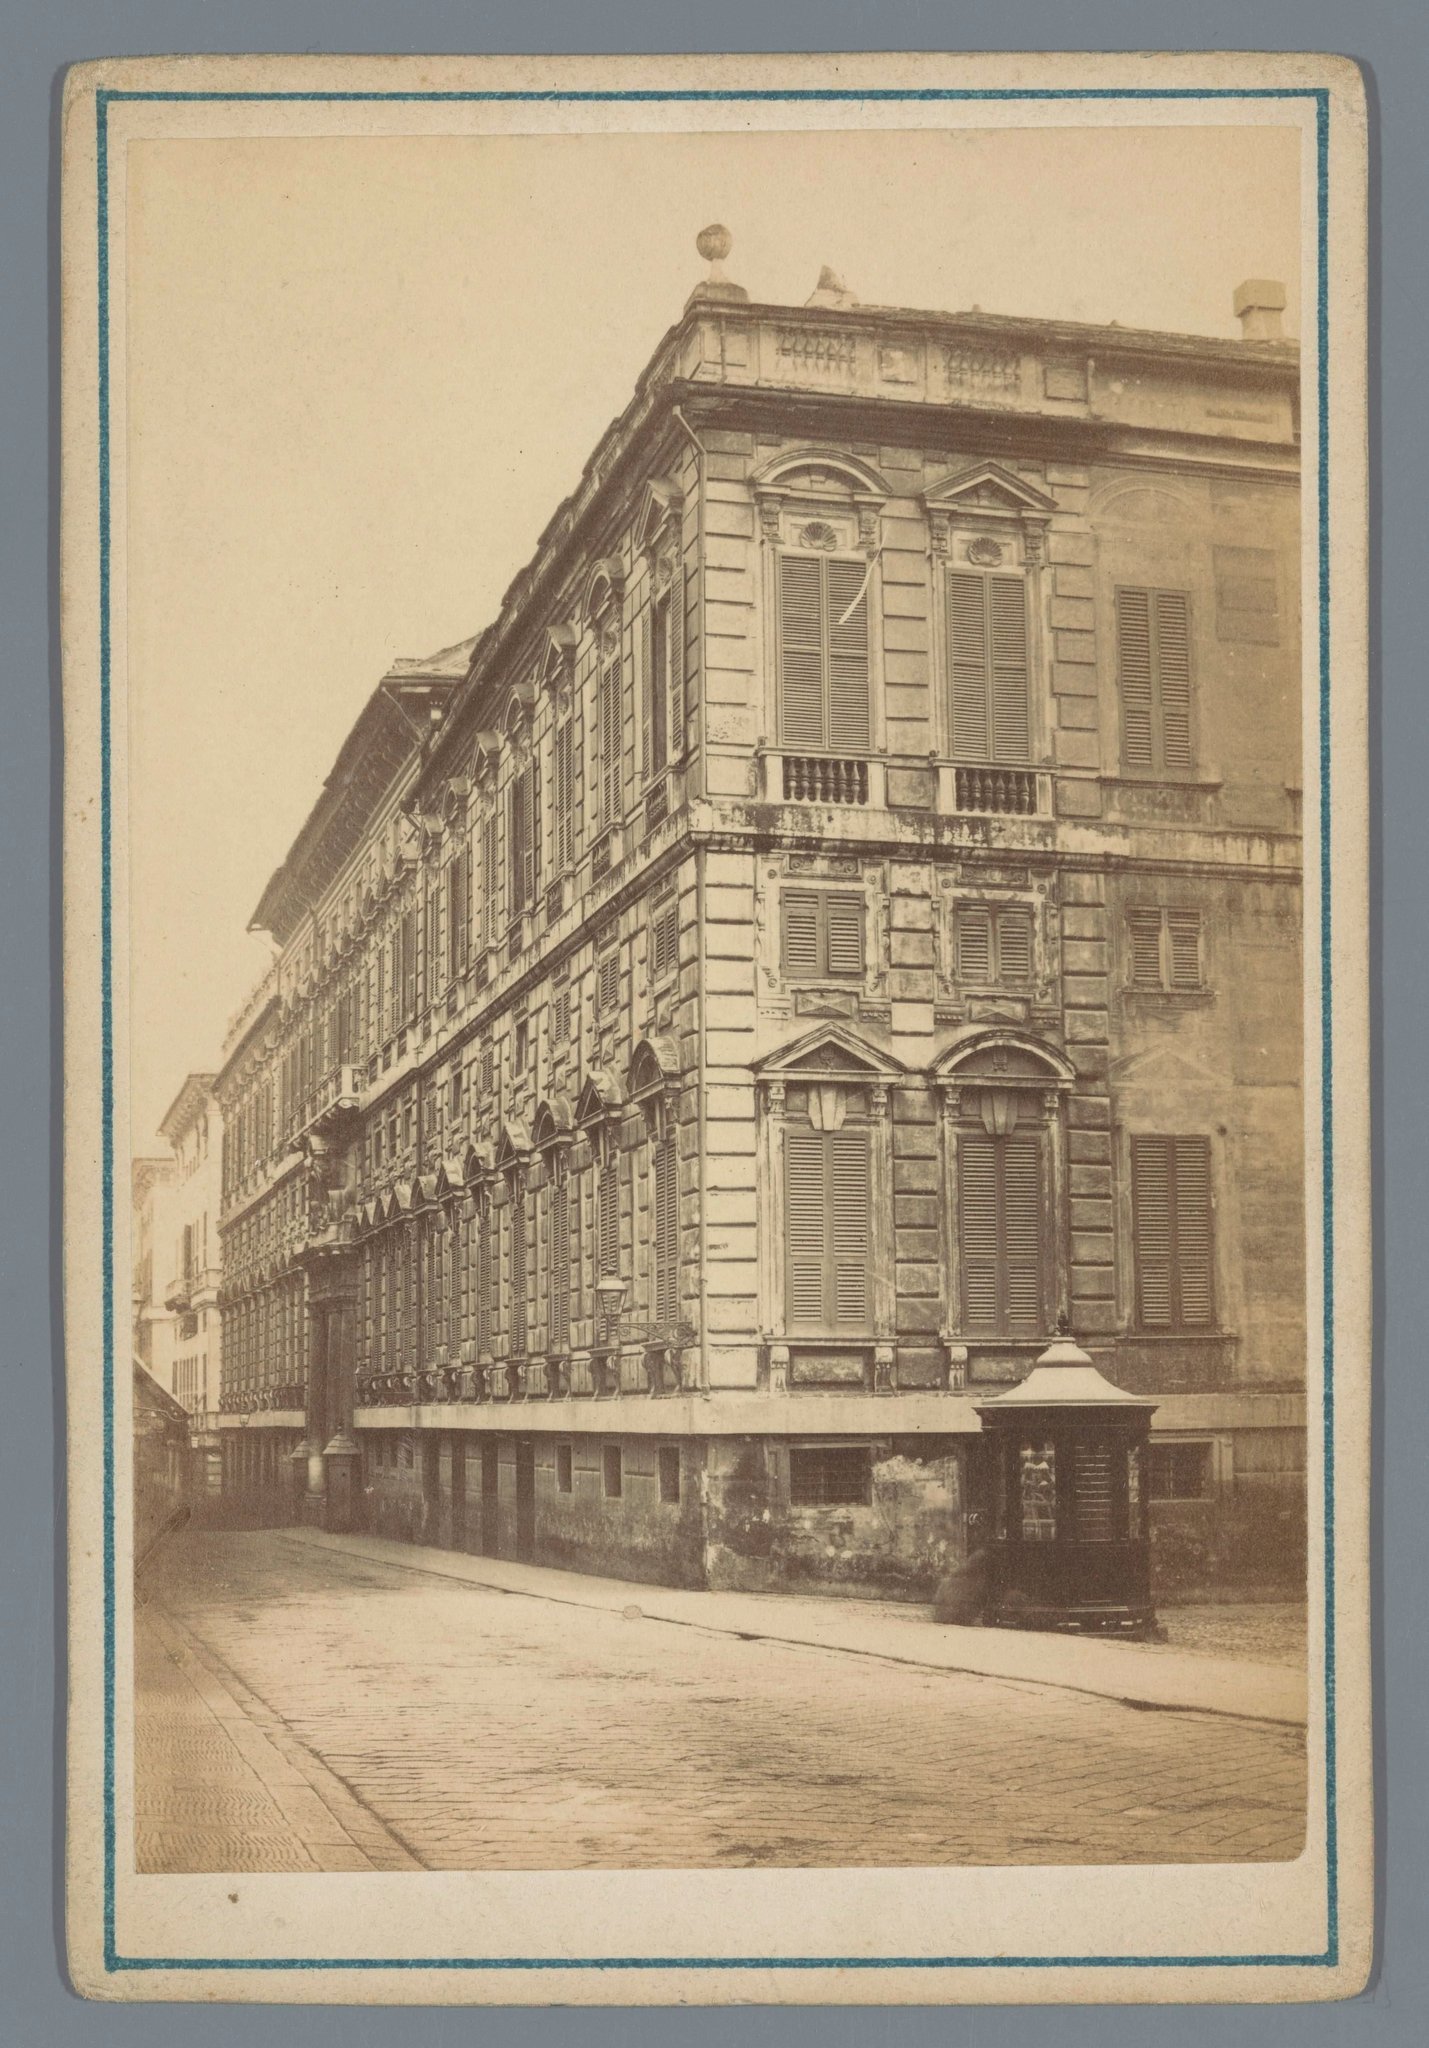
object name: cabinet photograph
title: Gezicht op Palazzo Negrone in Genua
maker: celestino degoix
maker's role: fotograaf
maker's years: 1825-1902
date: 1850-1900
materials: cardboard, photographic support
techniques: albumen print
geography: palazzo negrone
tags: palace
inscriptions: annotation: ‘genova Palazzo [...]’